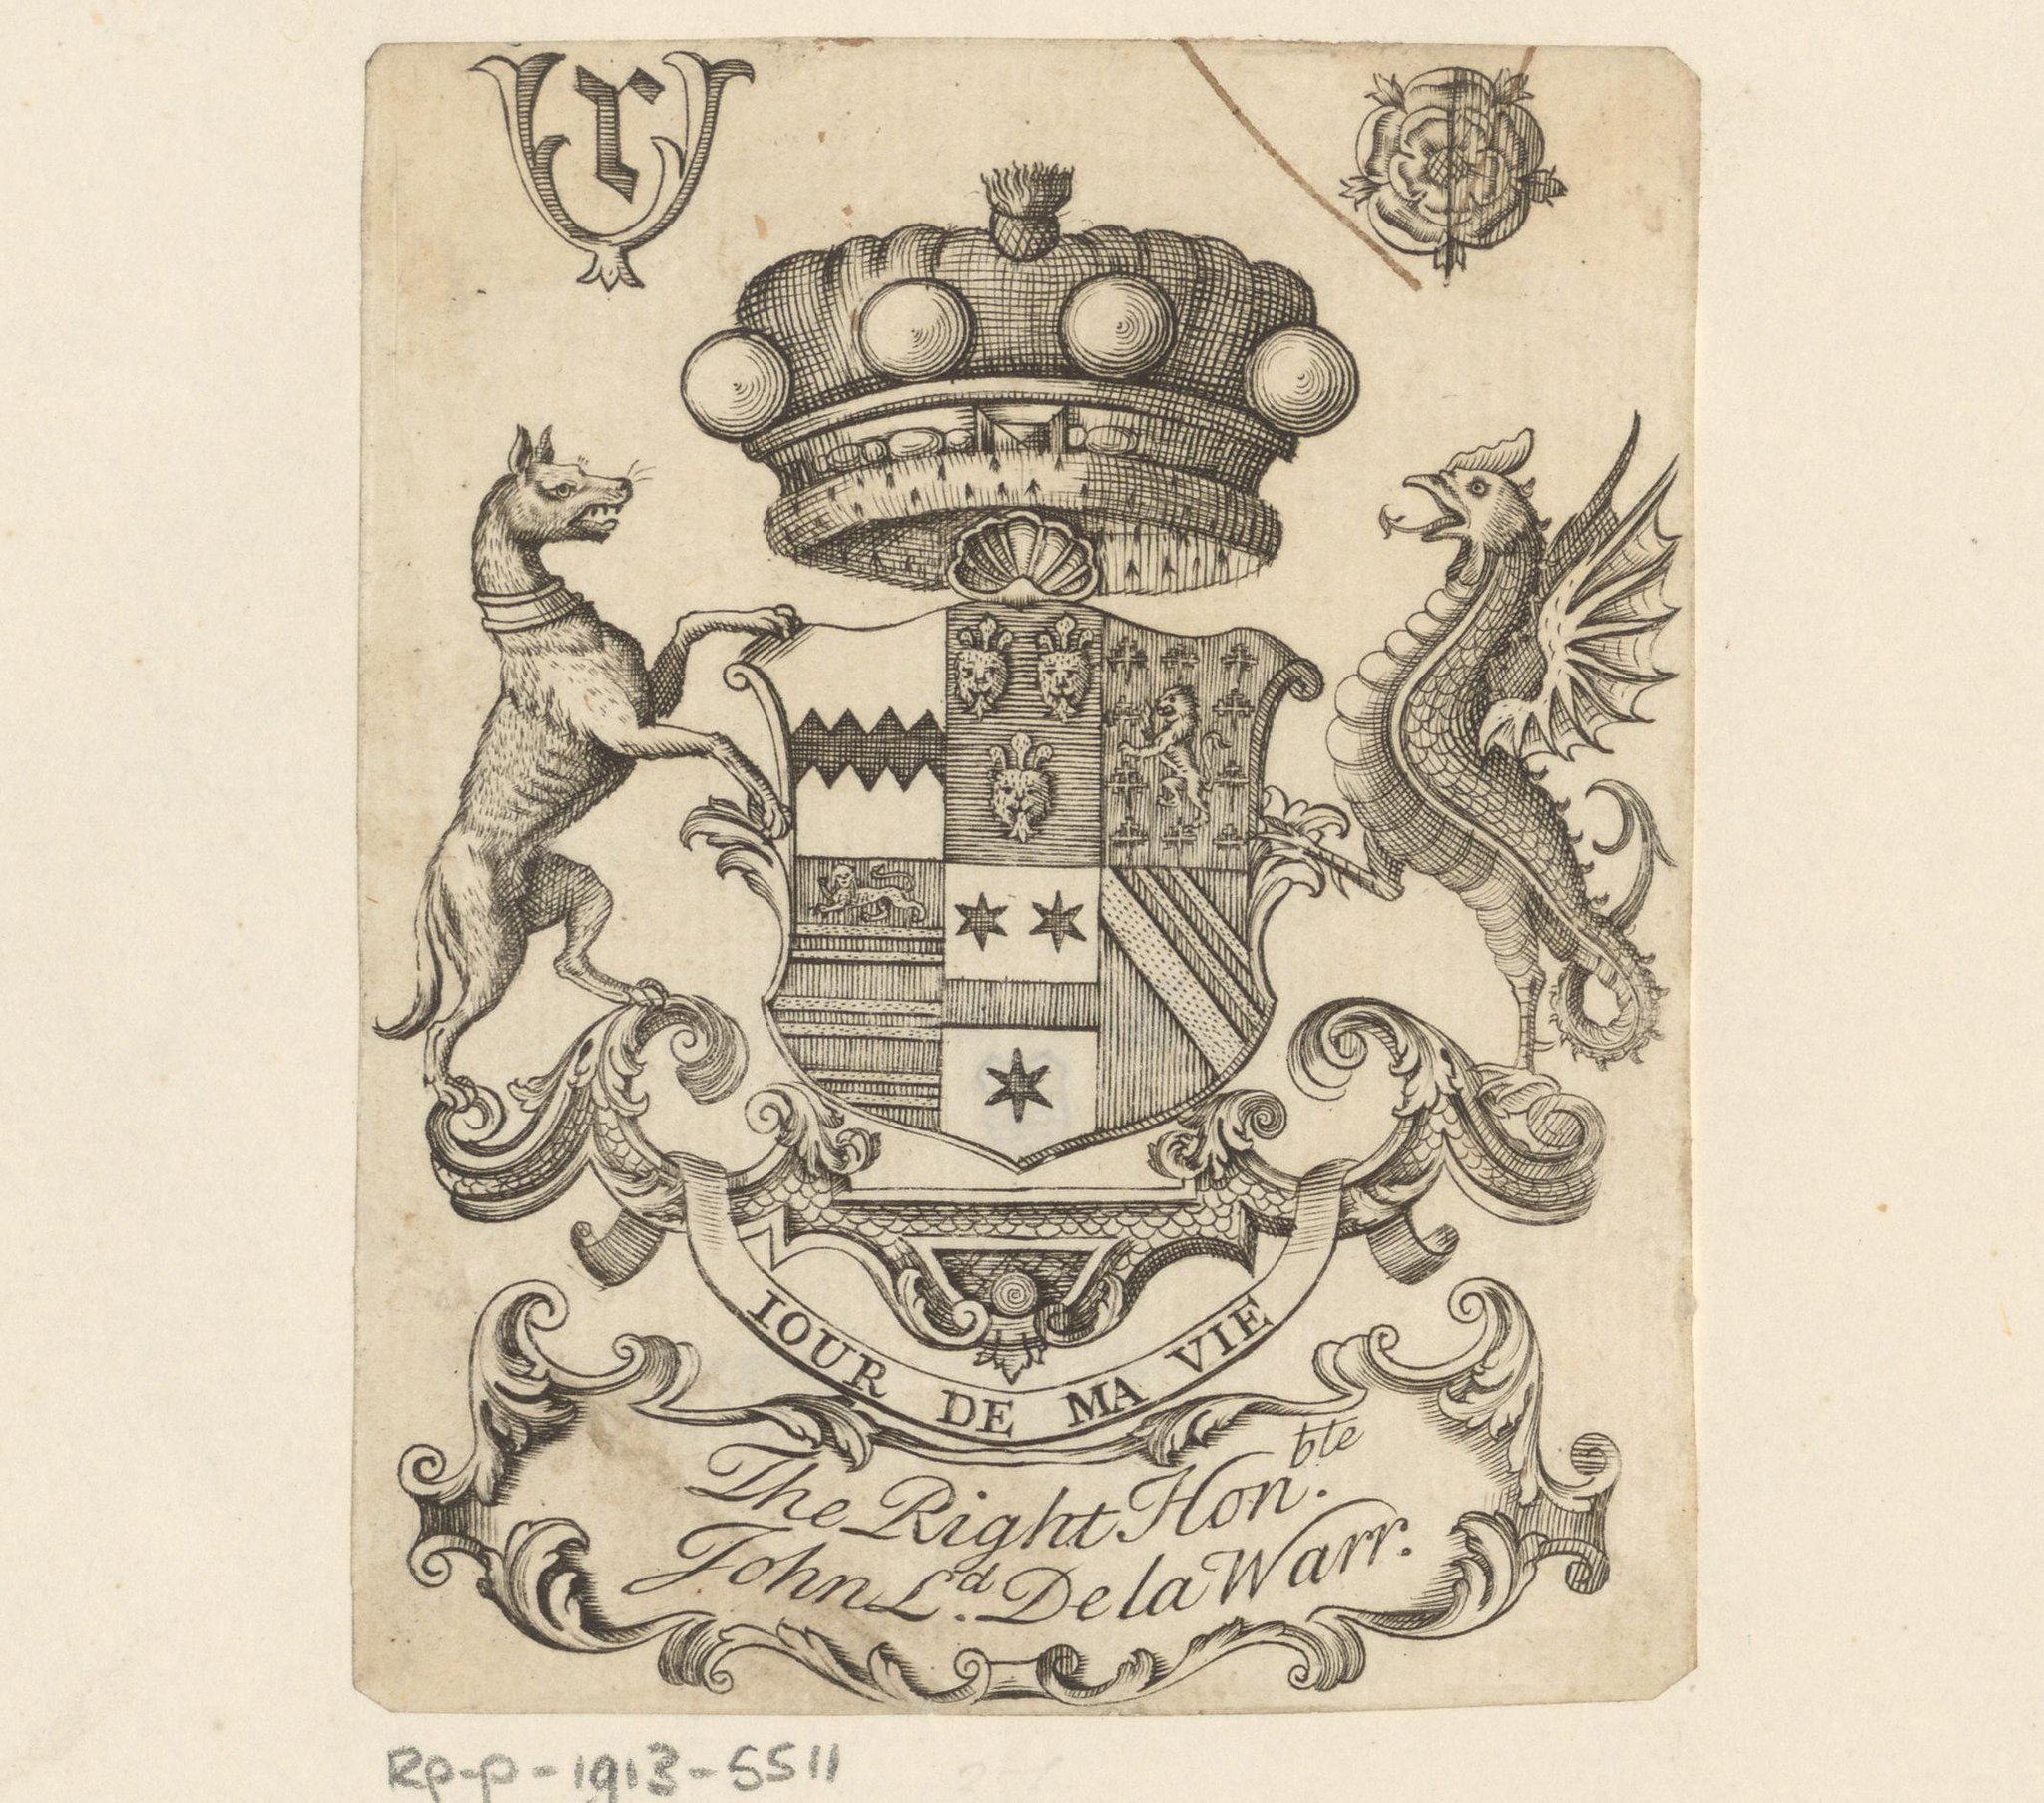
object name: bookplate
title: Ex libris van The Right Honble. John Ld. De la Warr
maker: Anonymous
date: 1700-1799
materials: paper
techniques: engraving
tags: armorial bearing, heraldry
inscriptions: collector's mark: Lugt 2760, collector's mark: Lugt 2233